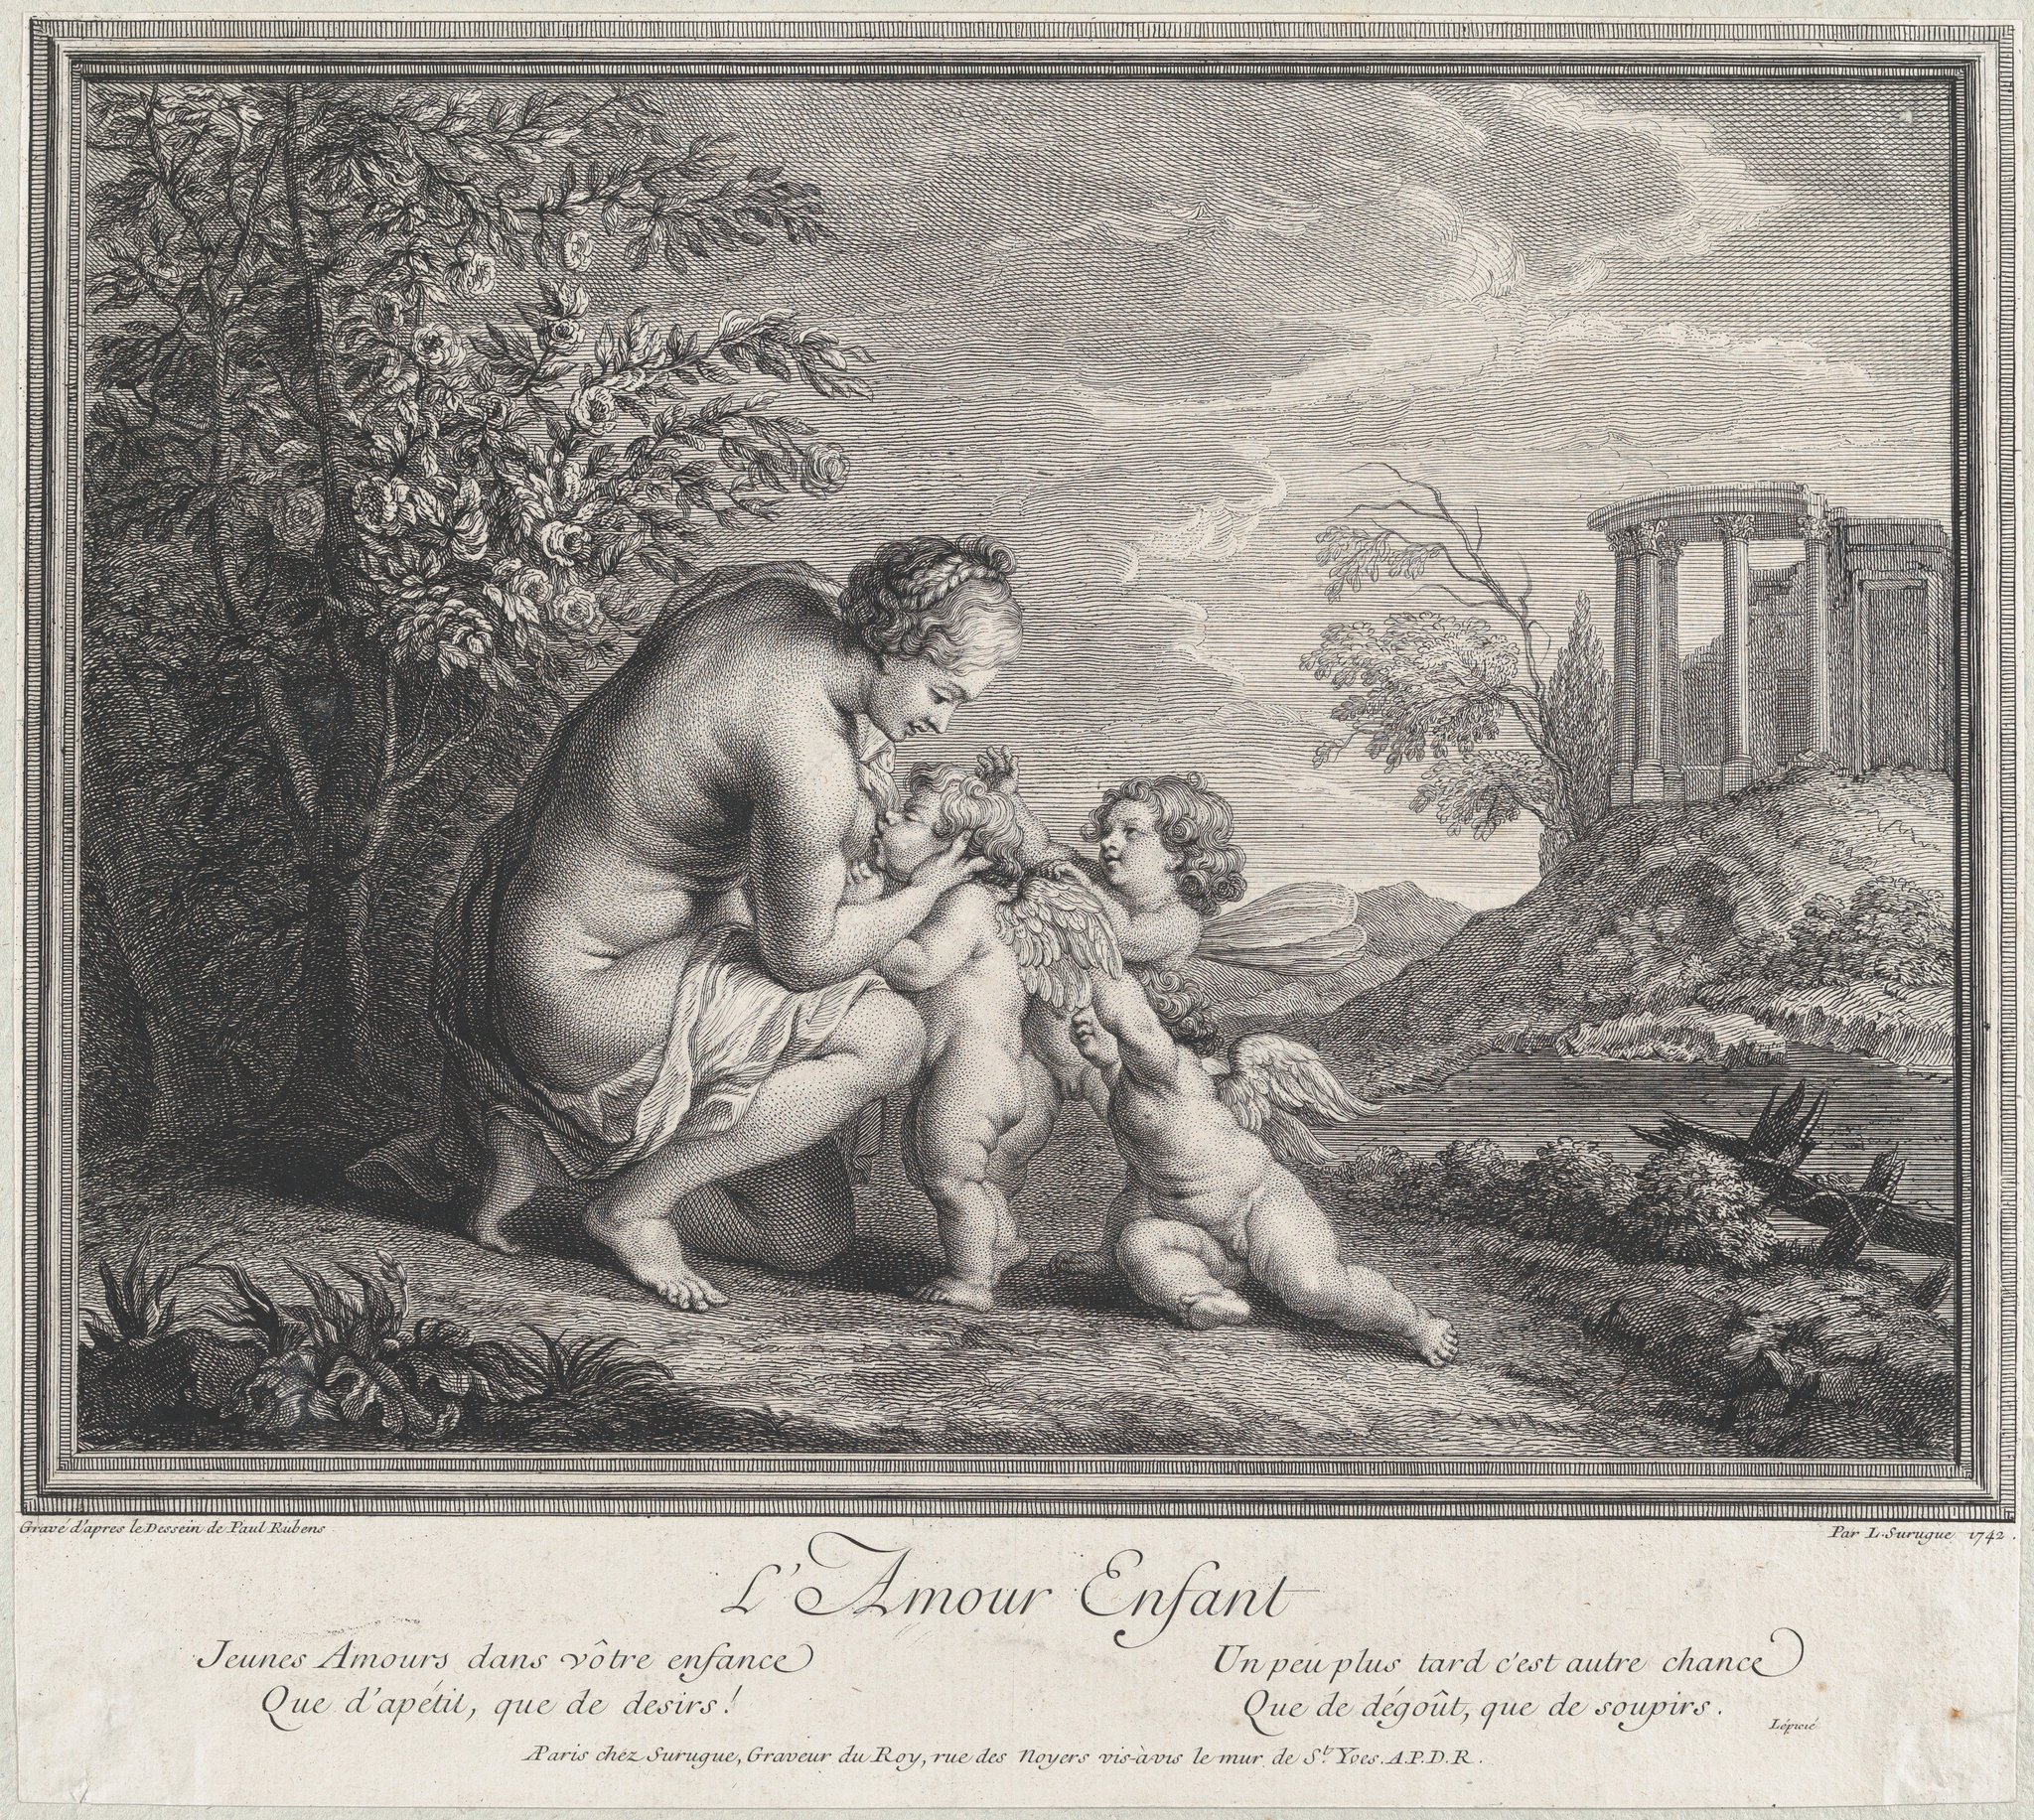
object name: print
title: Venus nursing three Cupids in a landscape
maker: louis surugue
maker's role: artist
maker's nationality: french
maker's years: 1686-1762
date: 1742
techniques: engraving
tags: ruins,cupid,venus,landscapes,trees